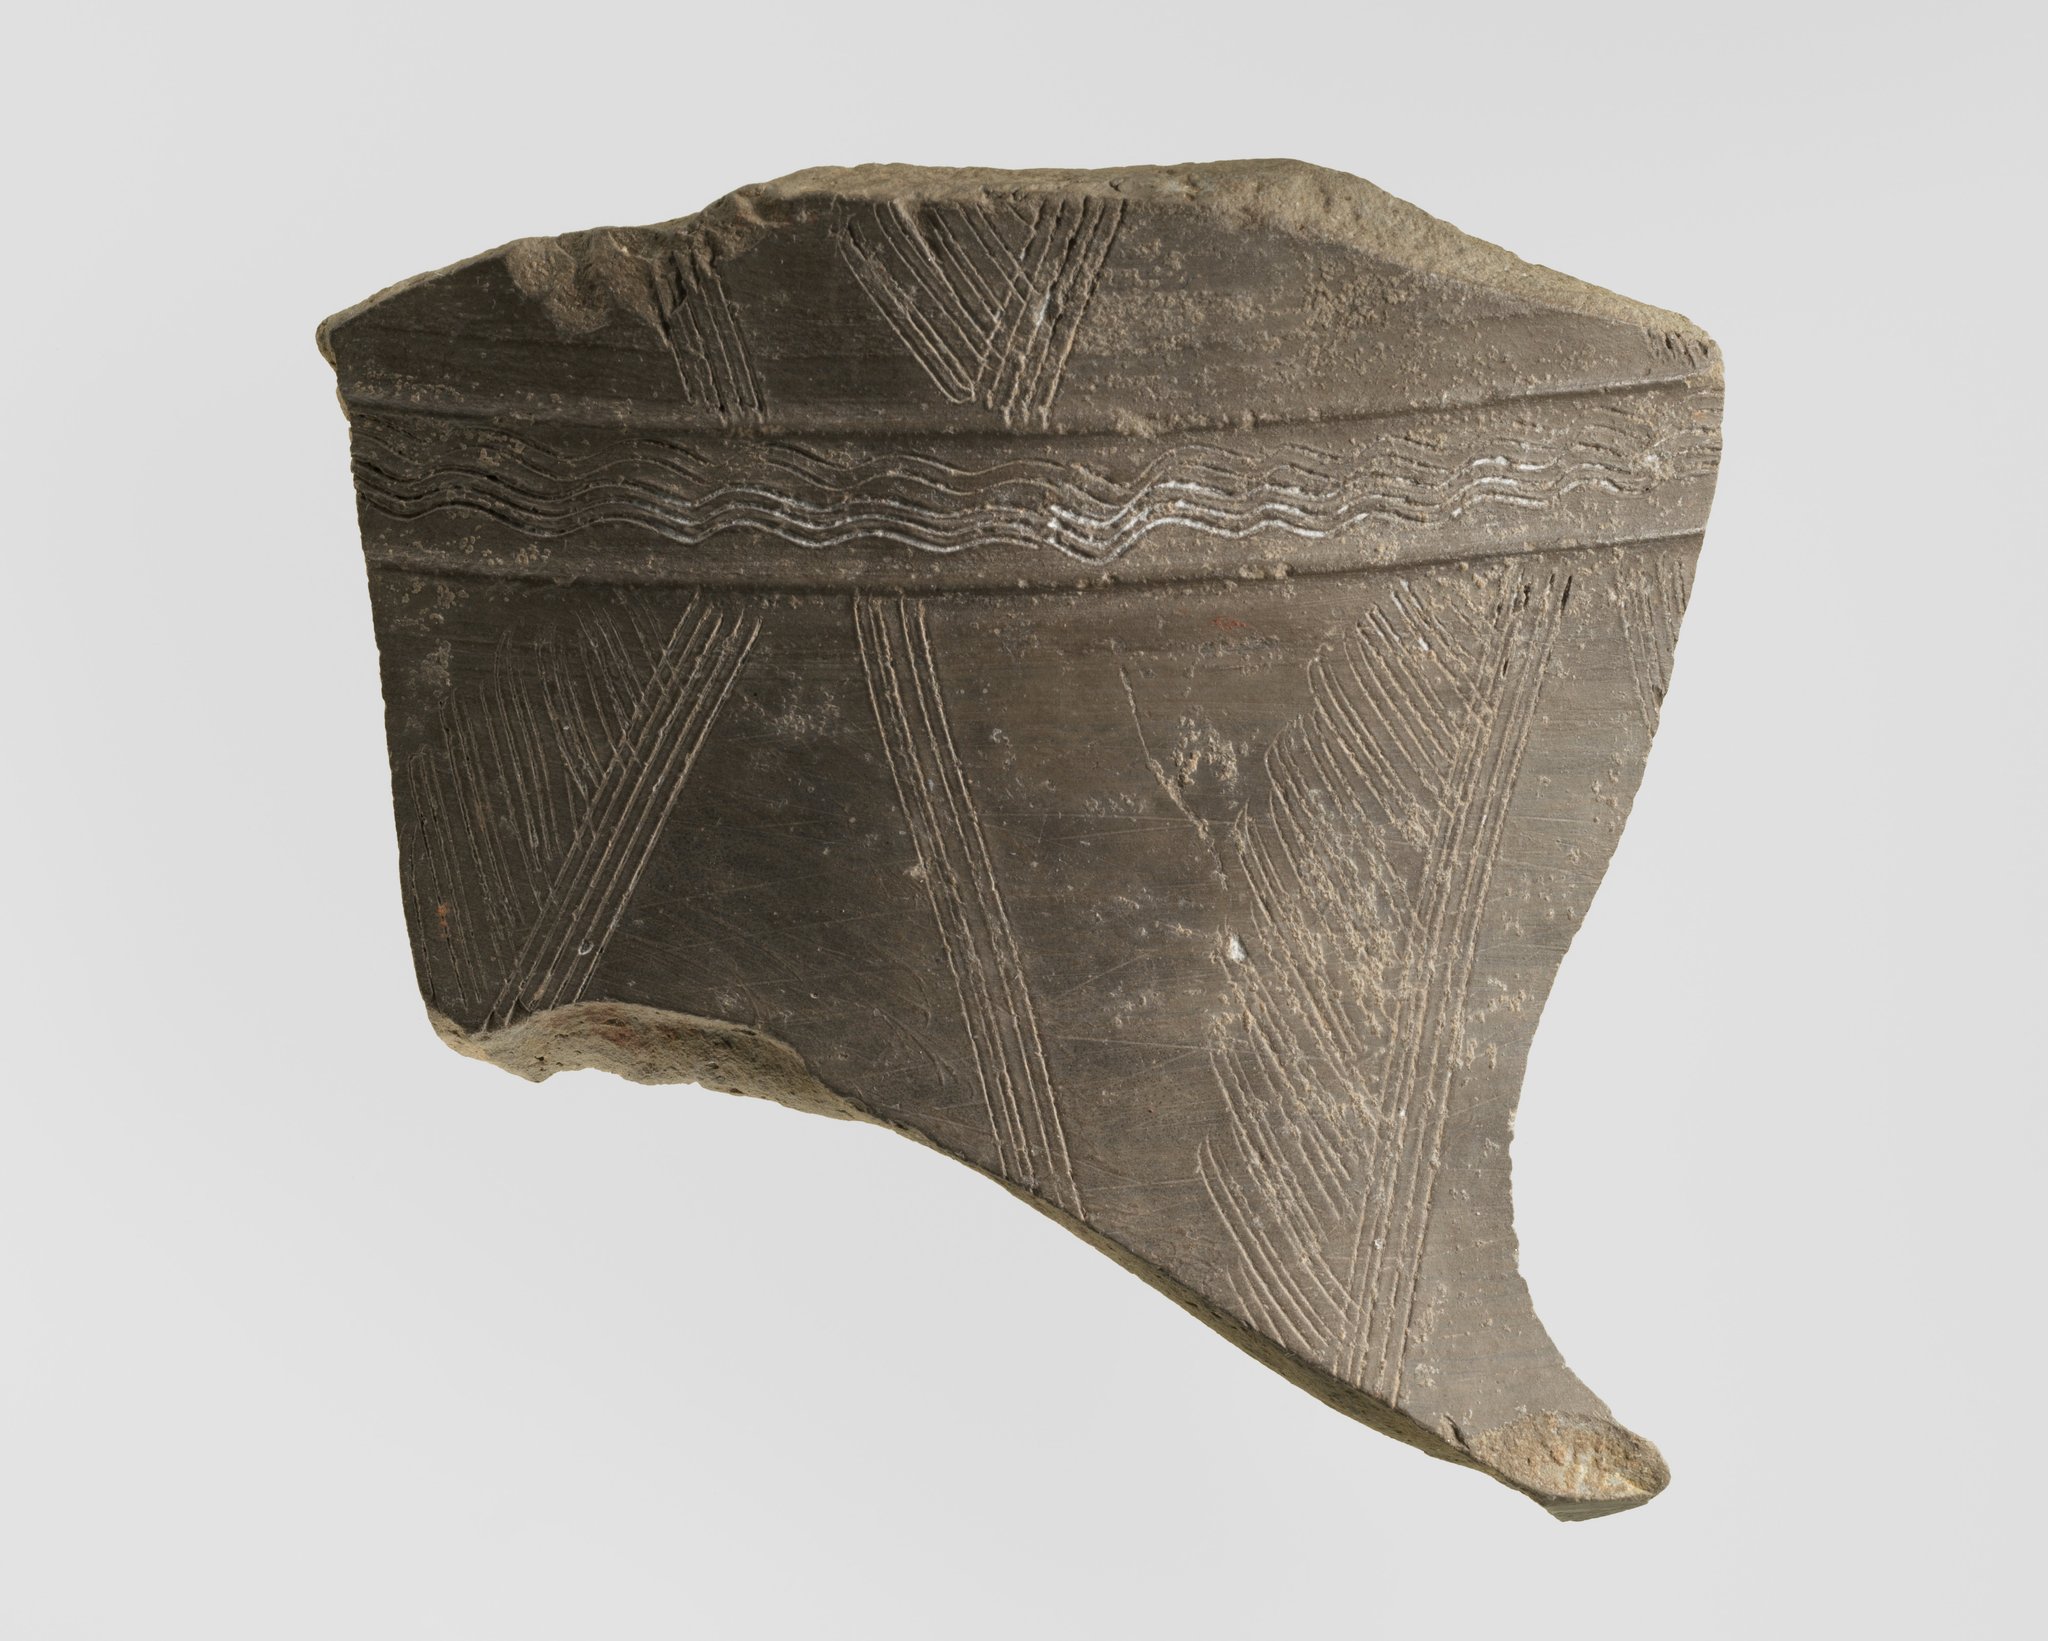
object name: sherd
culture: iranian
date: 3100-2500 BCE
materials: ceramic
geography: iran